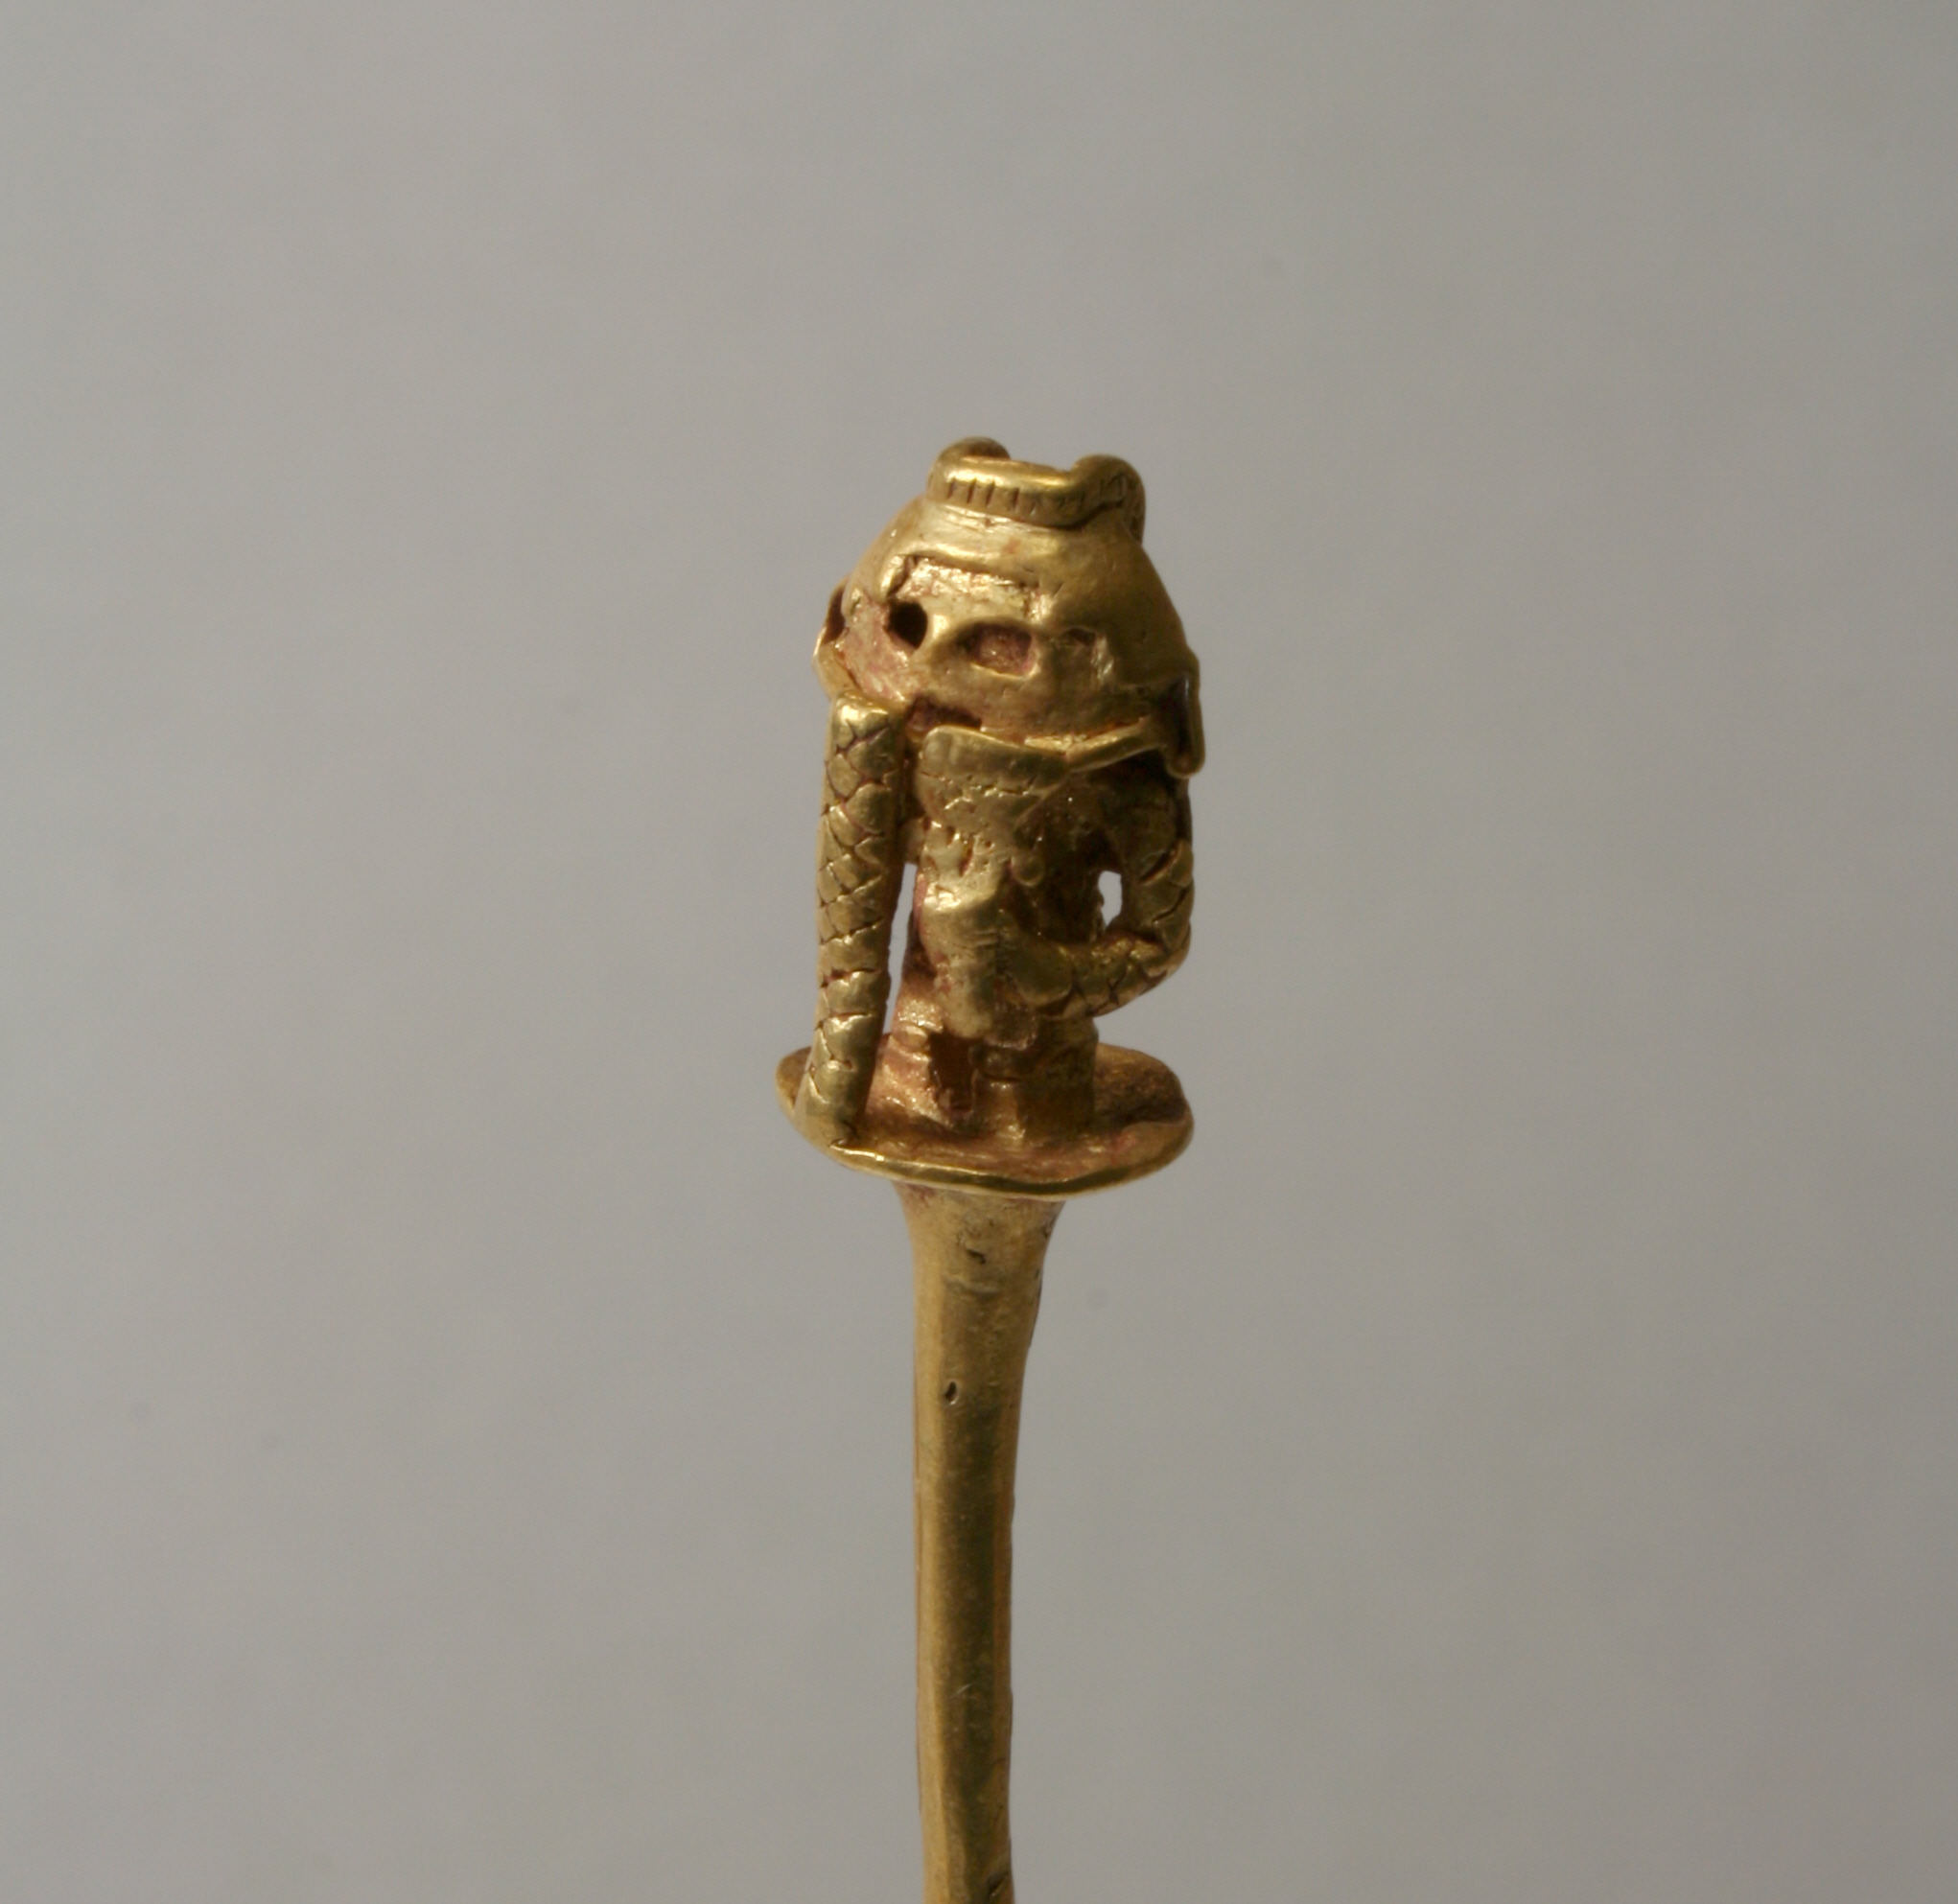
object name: lime dipper or pin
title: Lime Dipper or Pin, Figure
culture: calima or yotoco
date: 401-1000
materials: gold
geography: colombia